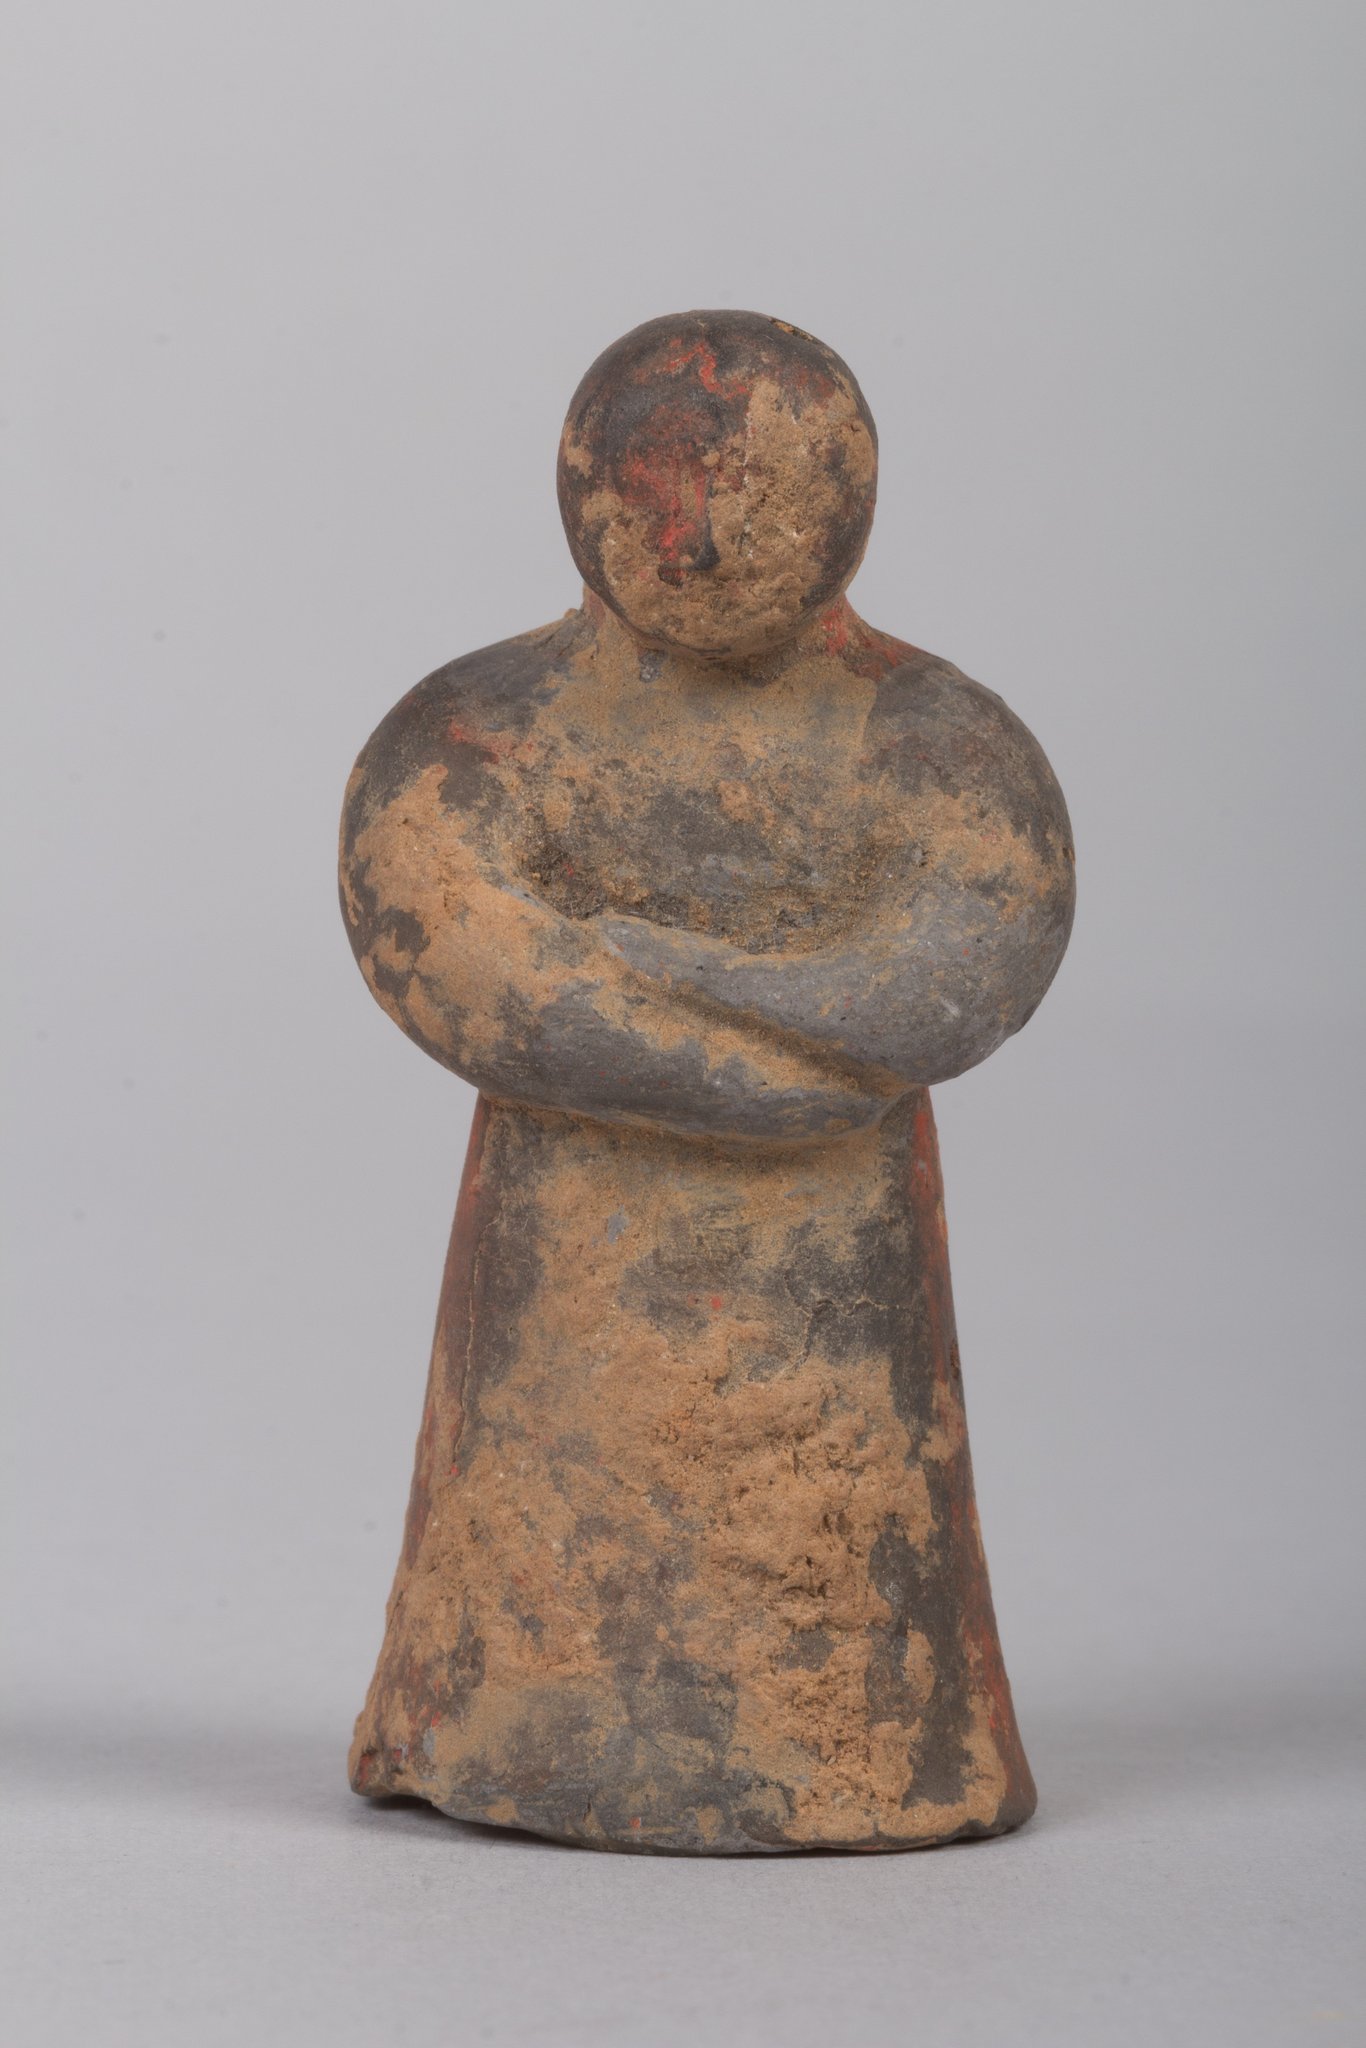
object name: figure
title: Figure of a woman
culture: chinese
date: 400-201 BCE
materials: clay